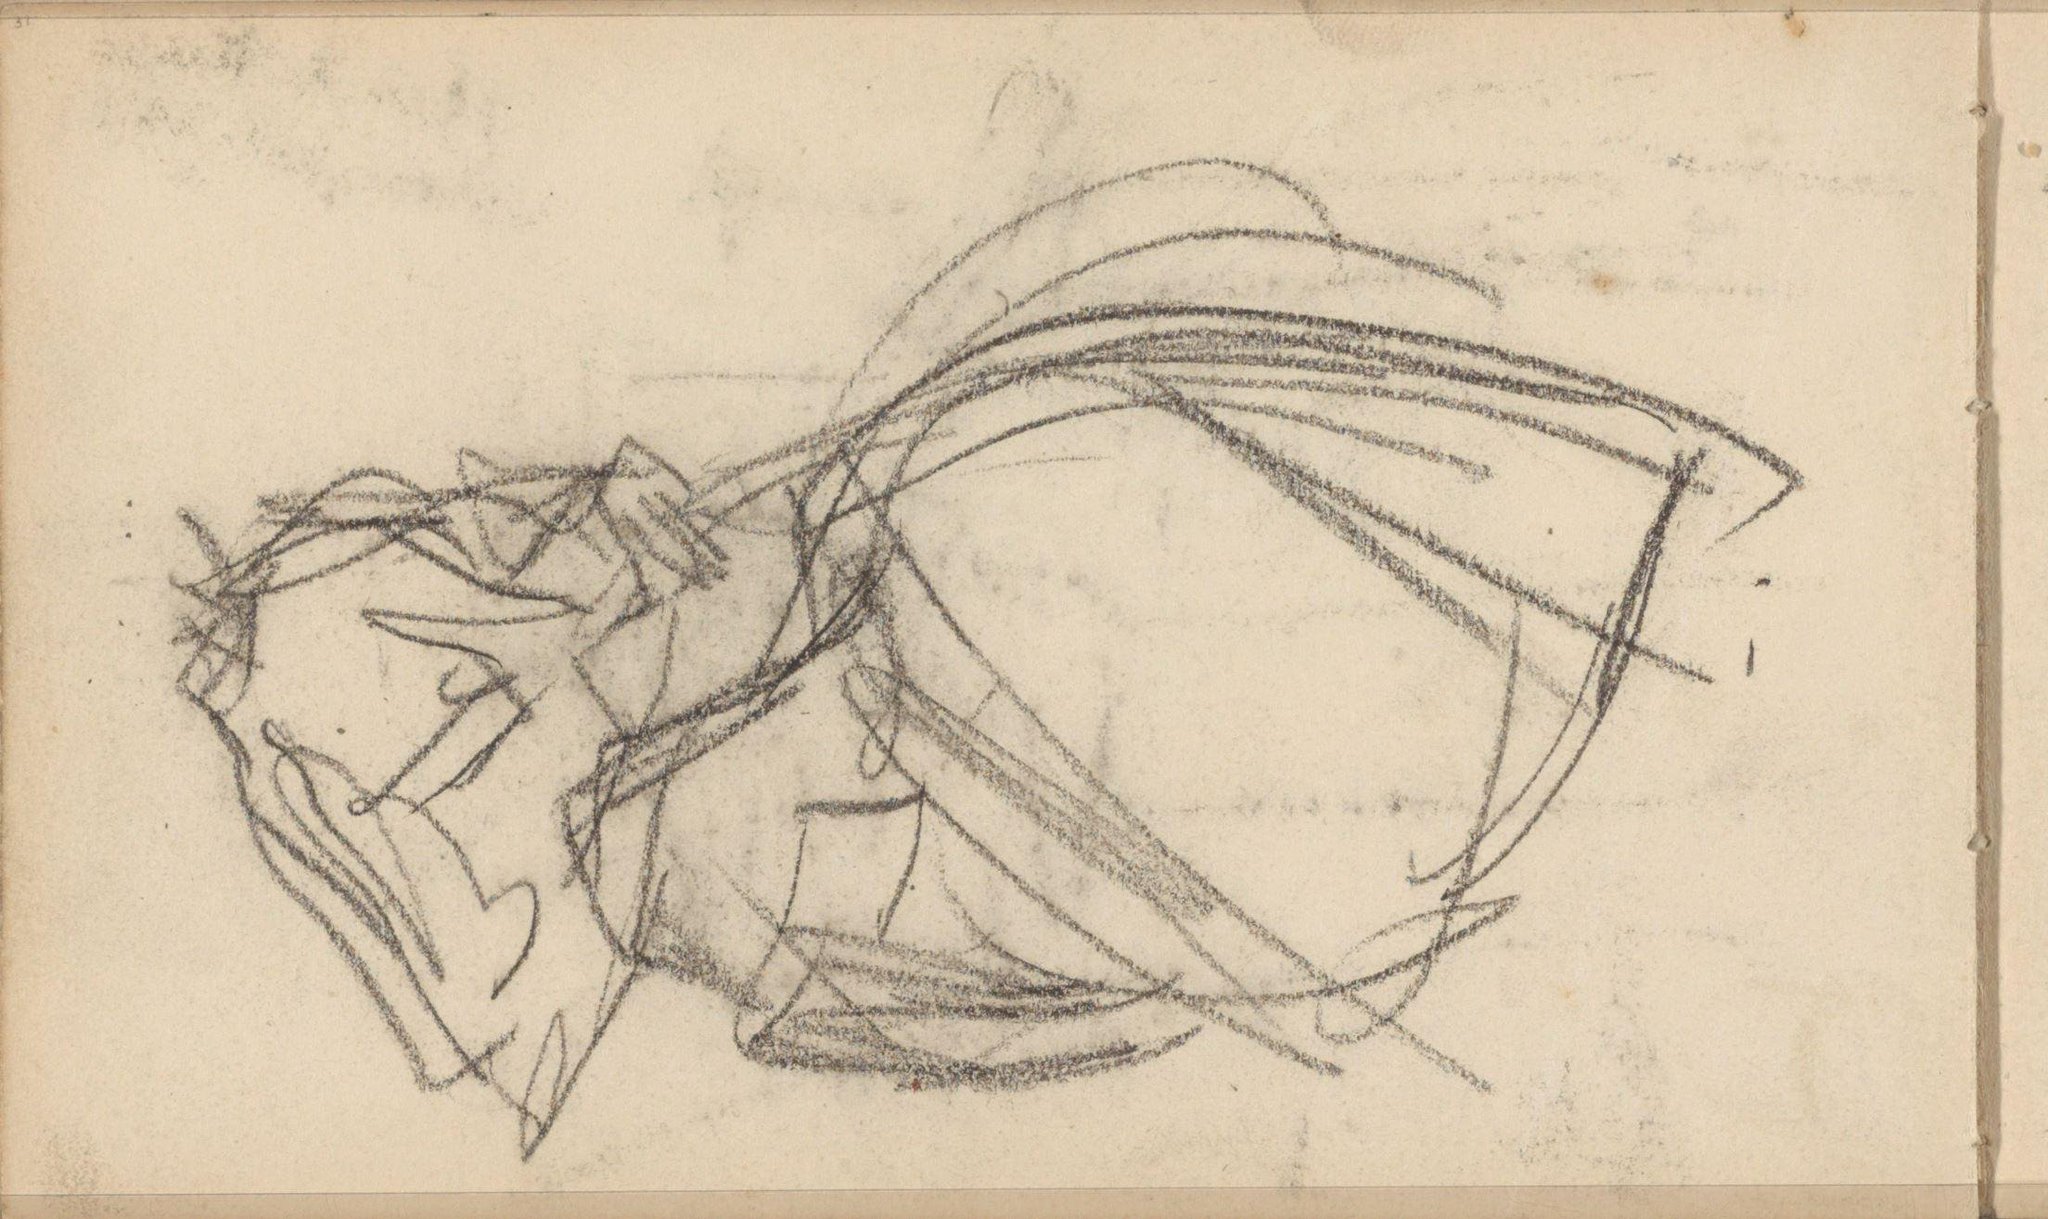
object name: sketchbook leaf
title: Figuurstudie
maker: george hendrik breitner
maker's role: draughtsman, painter, print maker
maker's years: 1857-1923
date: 1884-1886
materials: chalk, paper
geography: the hague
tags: adult woman, adult man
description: Pagina 31 uit een schetsboek met 35 bladen.